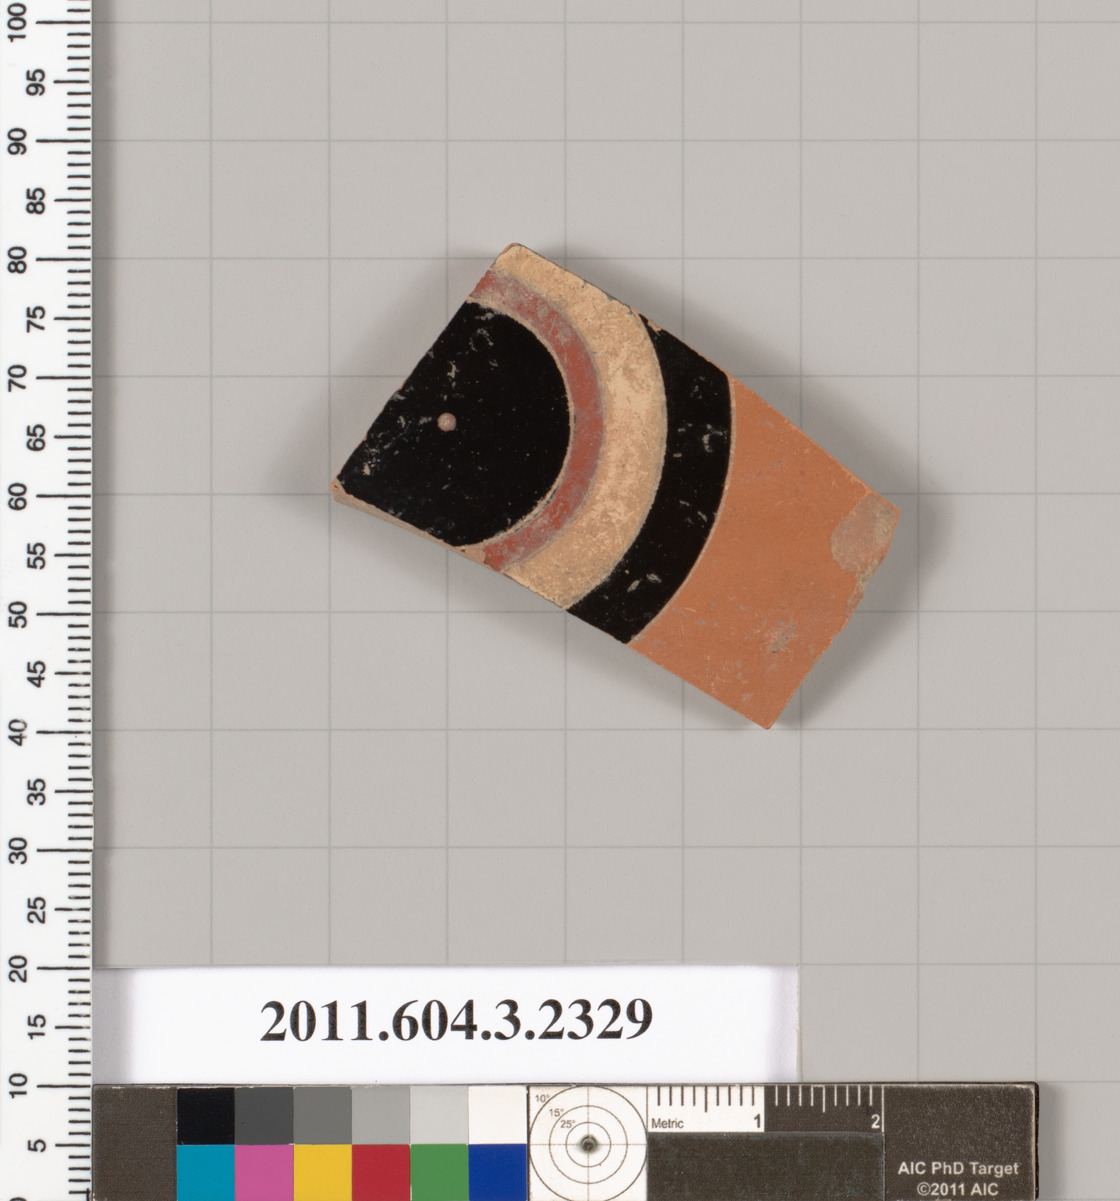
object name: kylix fragment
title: Terracotta fragment of a kylix: eye-cup (drinking cup)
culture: greek, attic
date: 540-520 BCE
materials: terracotta